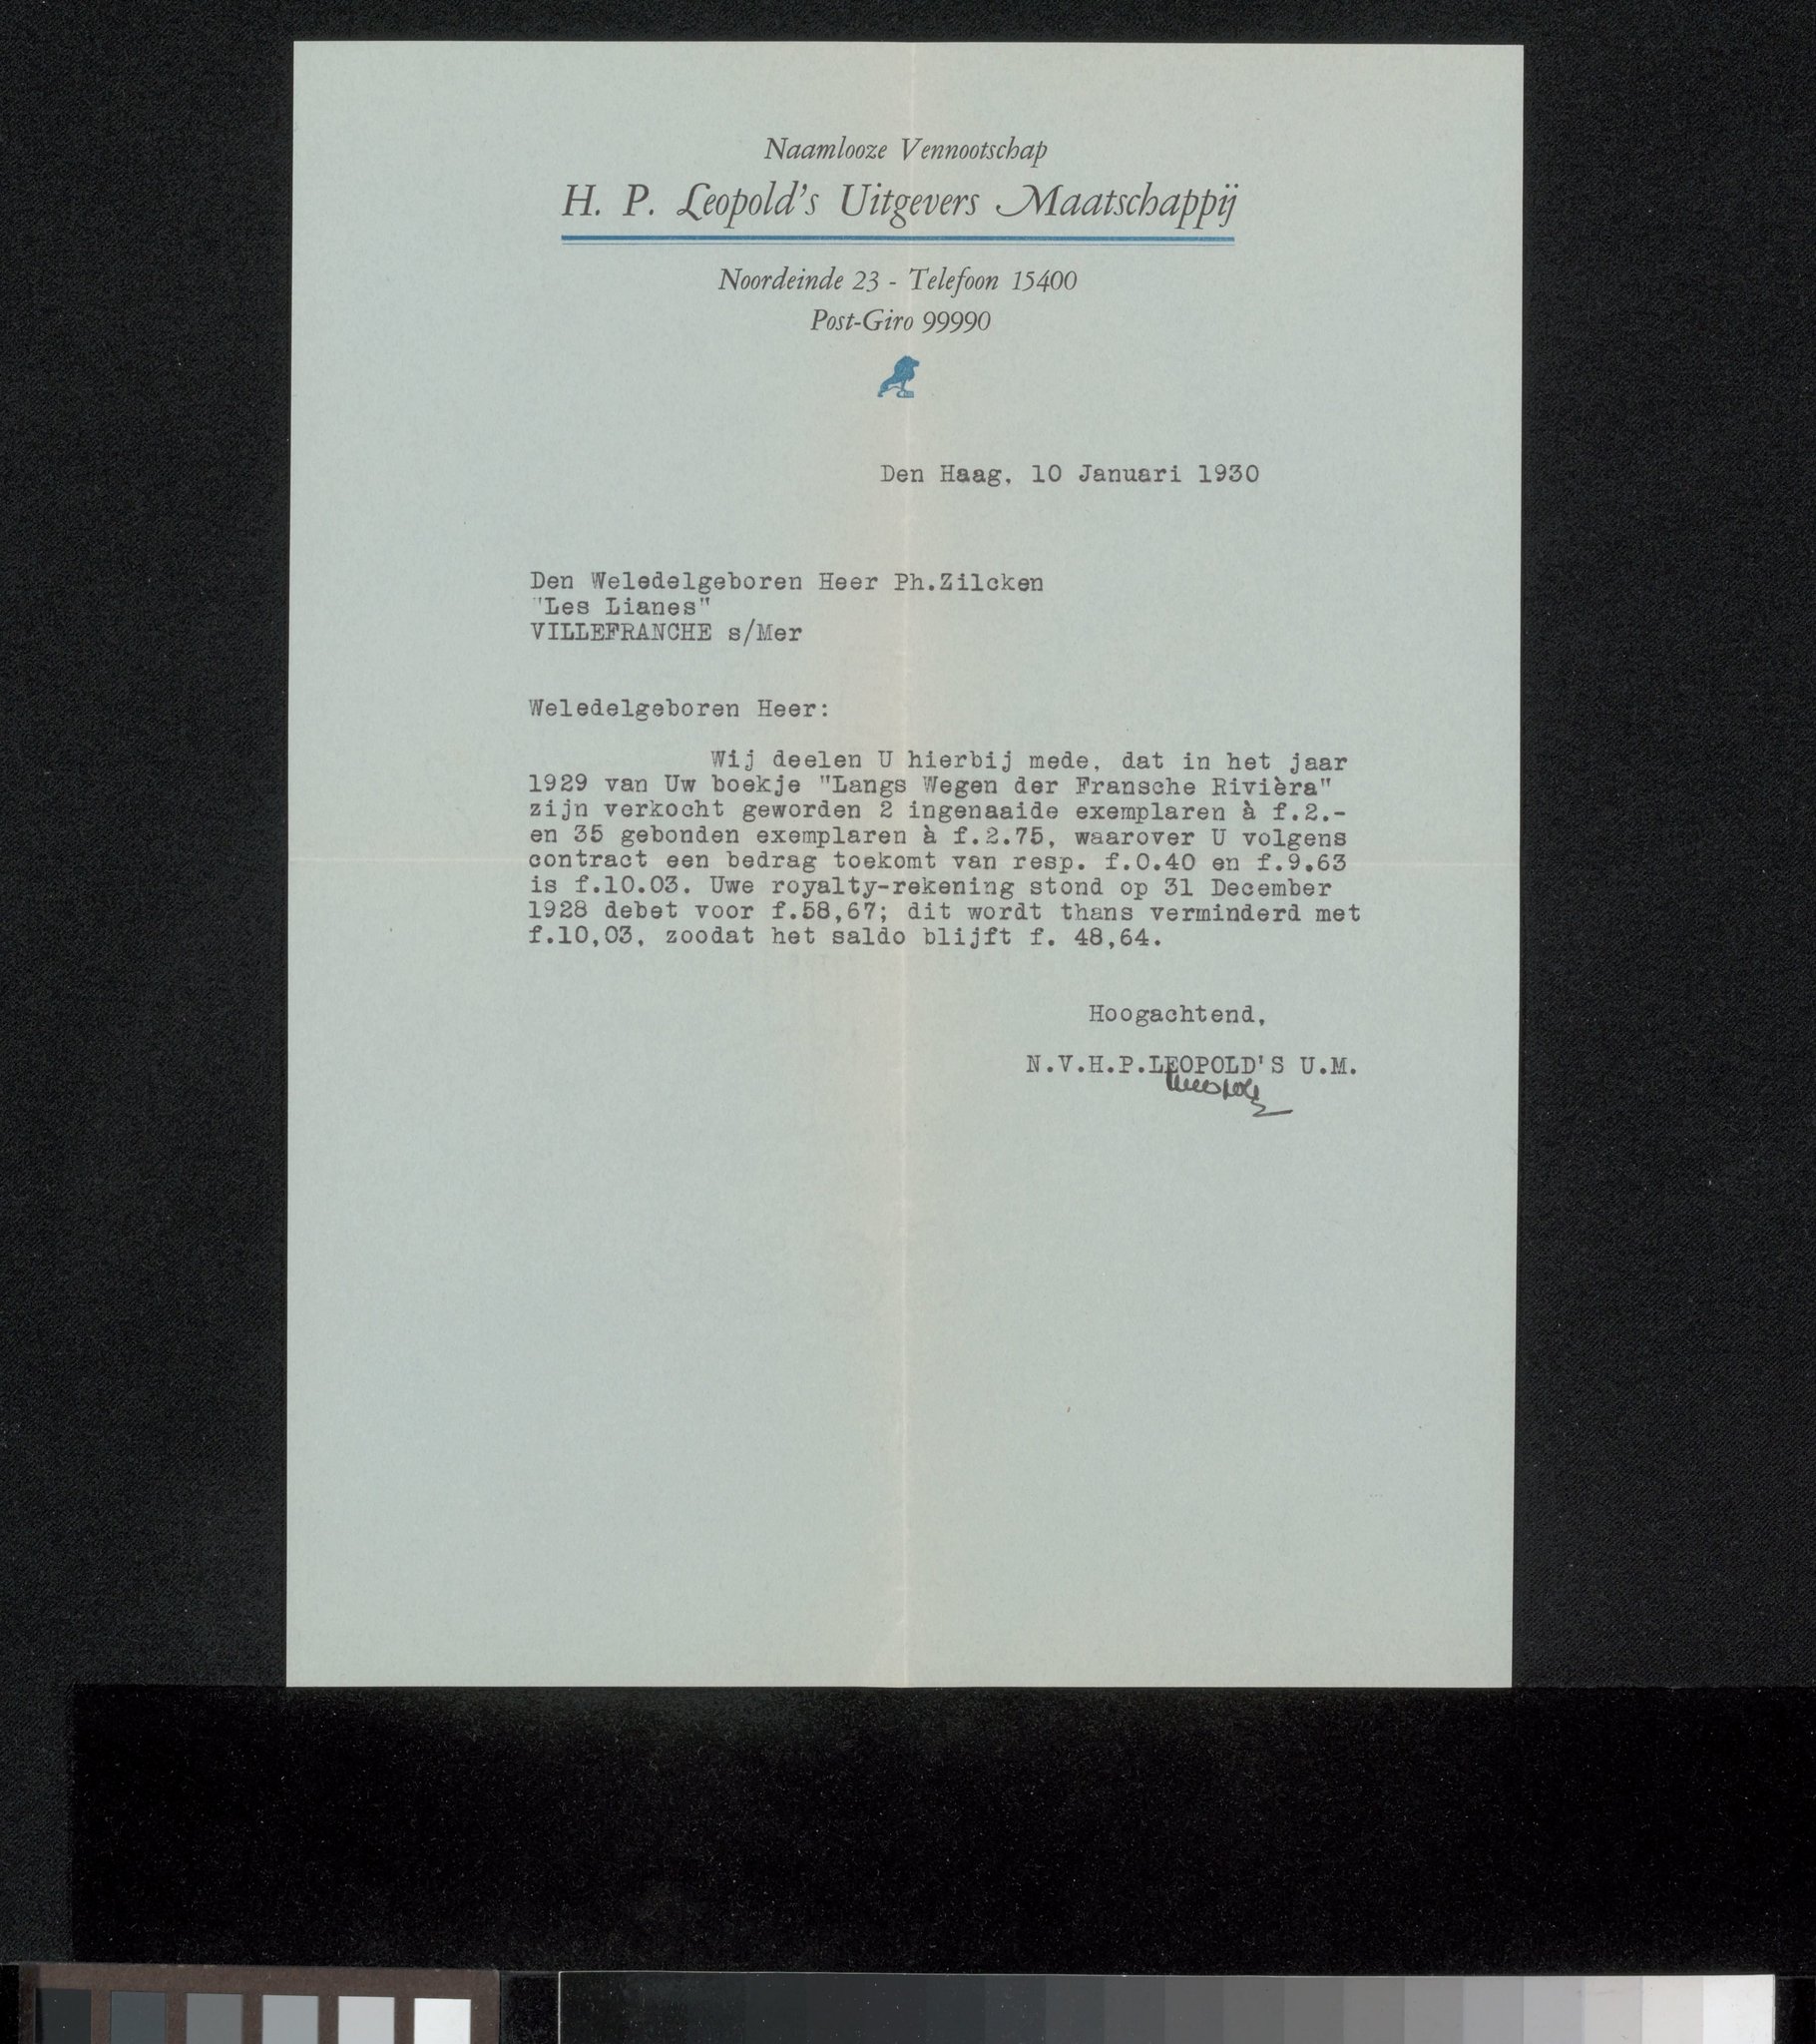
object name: letter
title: Brief aan Philip Zilcken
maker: Anonymous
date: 1930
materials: ink, paper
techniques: pen, printing, typewriting, writing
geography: the hague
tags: the hague, painter, draughtsman, philip zilcken, money, printed matter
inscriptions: watermark